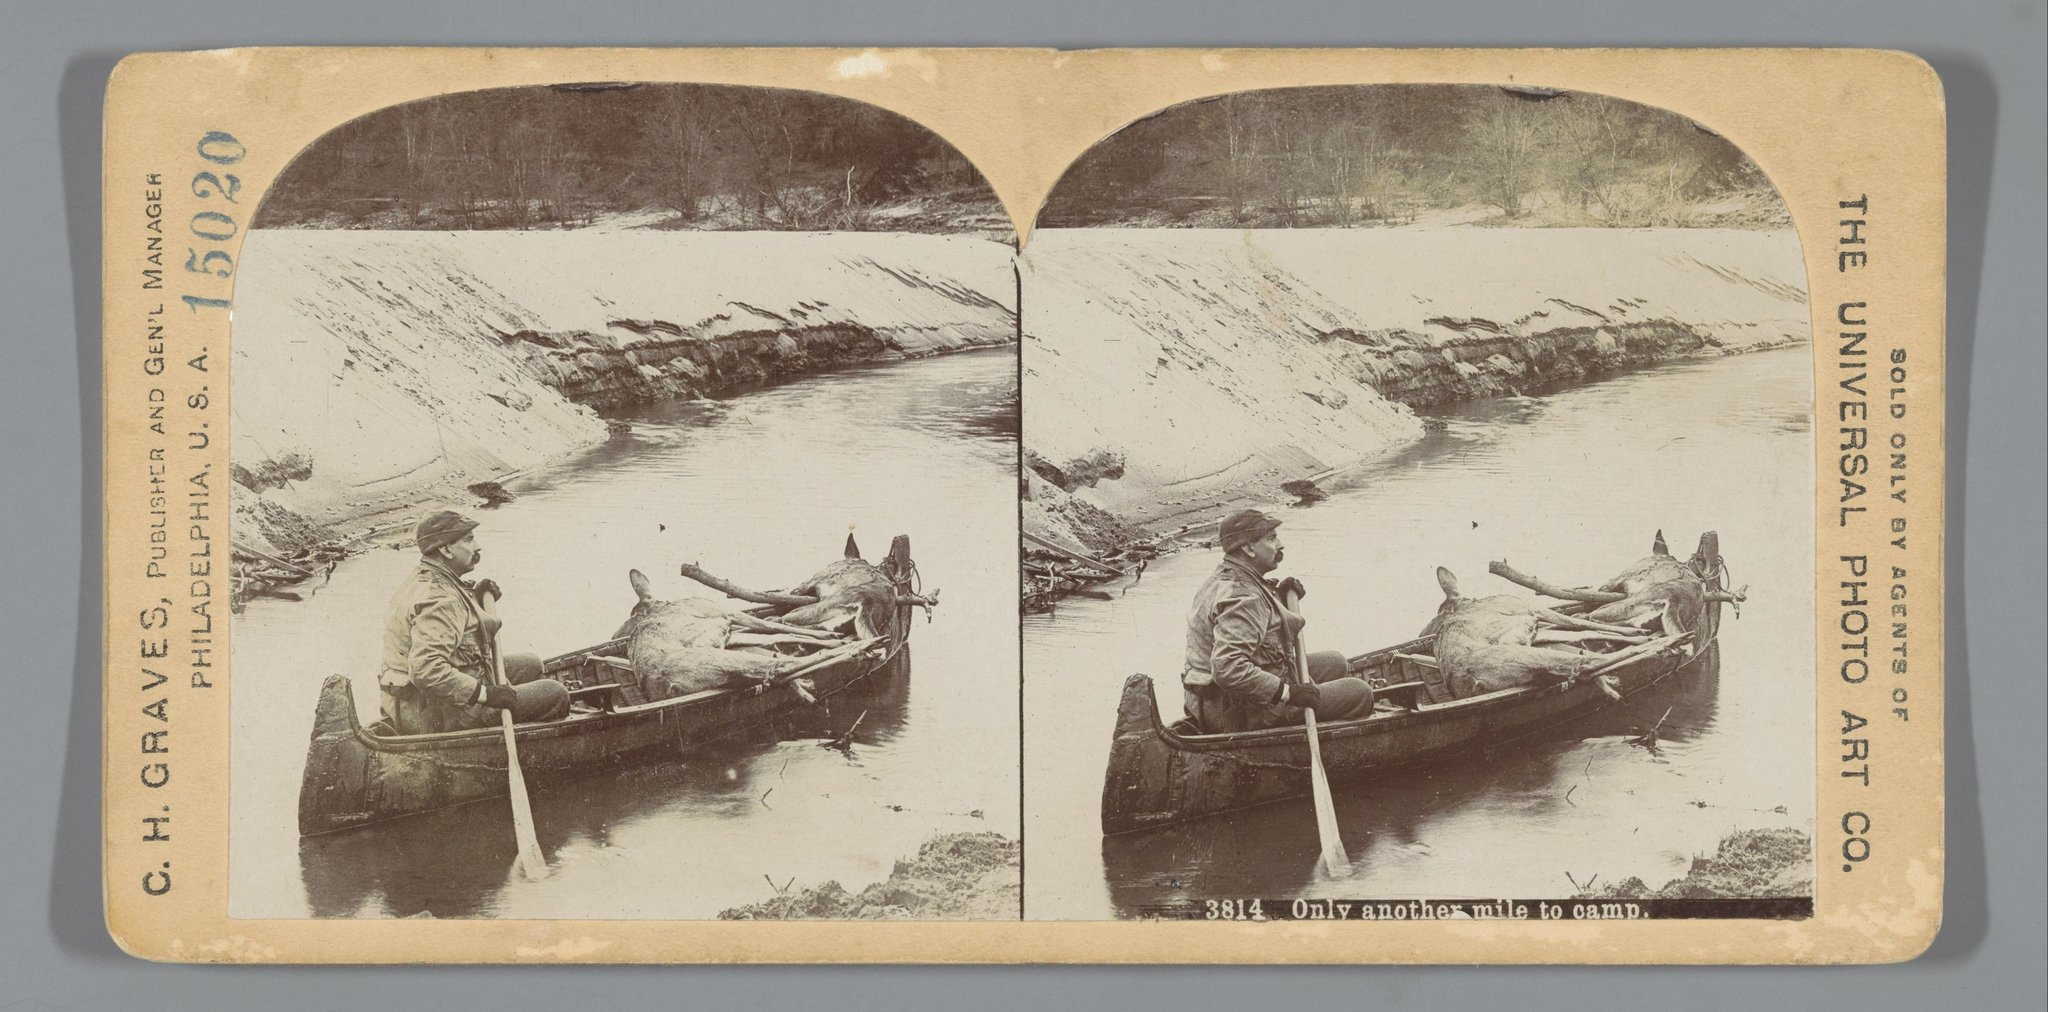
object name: stereograph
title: Only another mile to camp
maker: Anonymous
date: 1895-1910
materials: cardboard, photographic support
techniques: carbon print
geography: philadelphia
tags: hunter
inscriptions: number: ‘15020’, number: ‘3814’